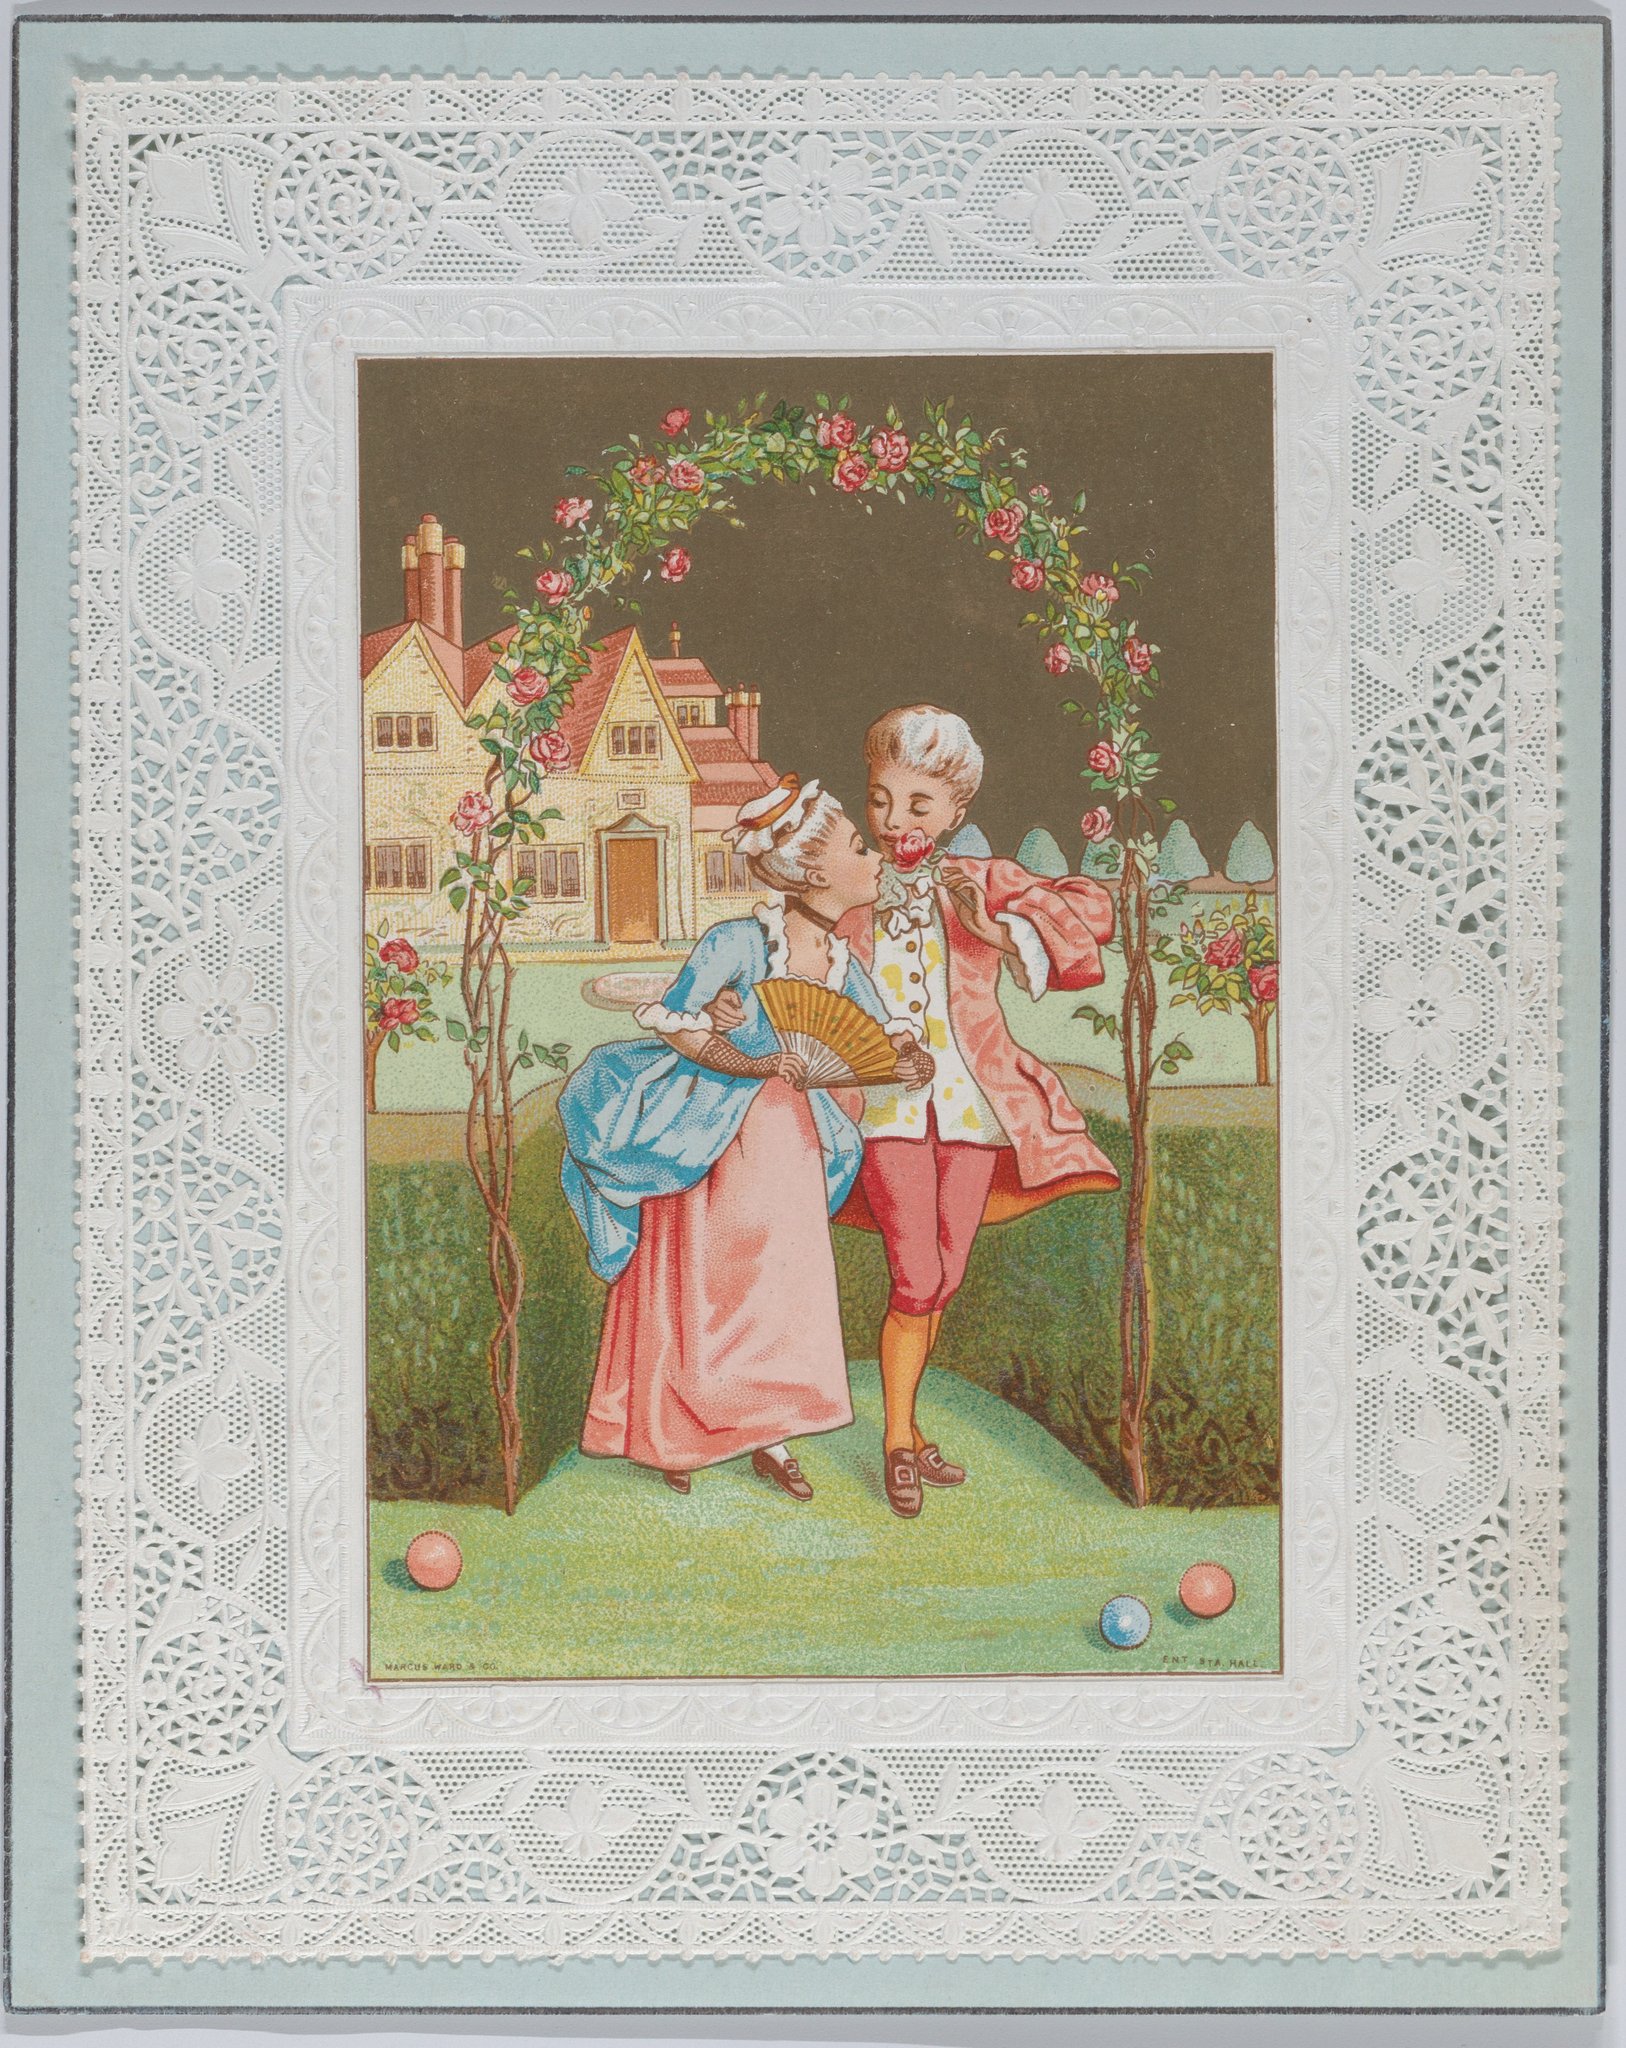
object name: valentine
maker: kate greenaway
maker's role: artist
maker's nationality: british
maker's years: 1846-1901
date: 1880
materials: gold, lace, paper, watercolor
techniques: chromolithography, embossing, gilding, lithograph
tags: couples,men,women